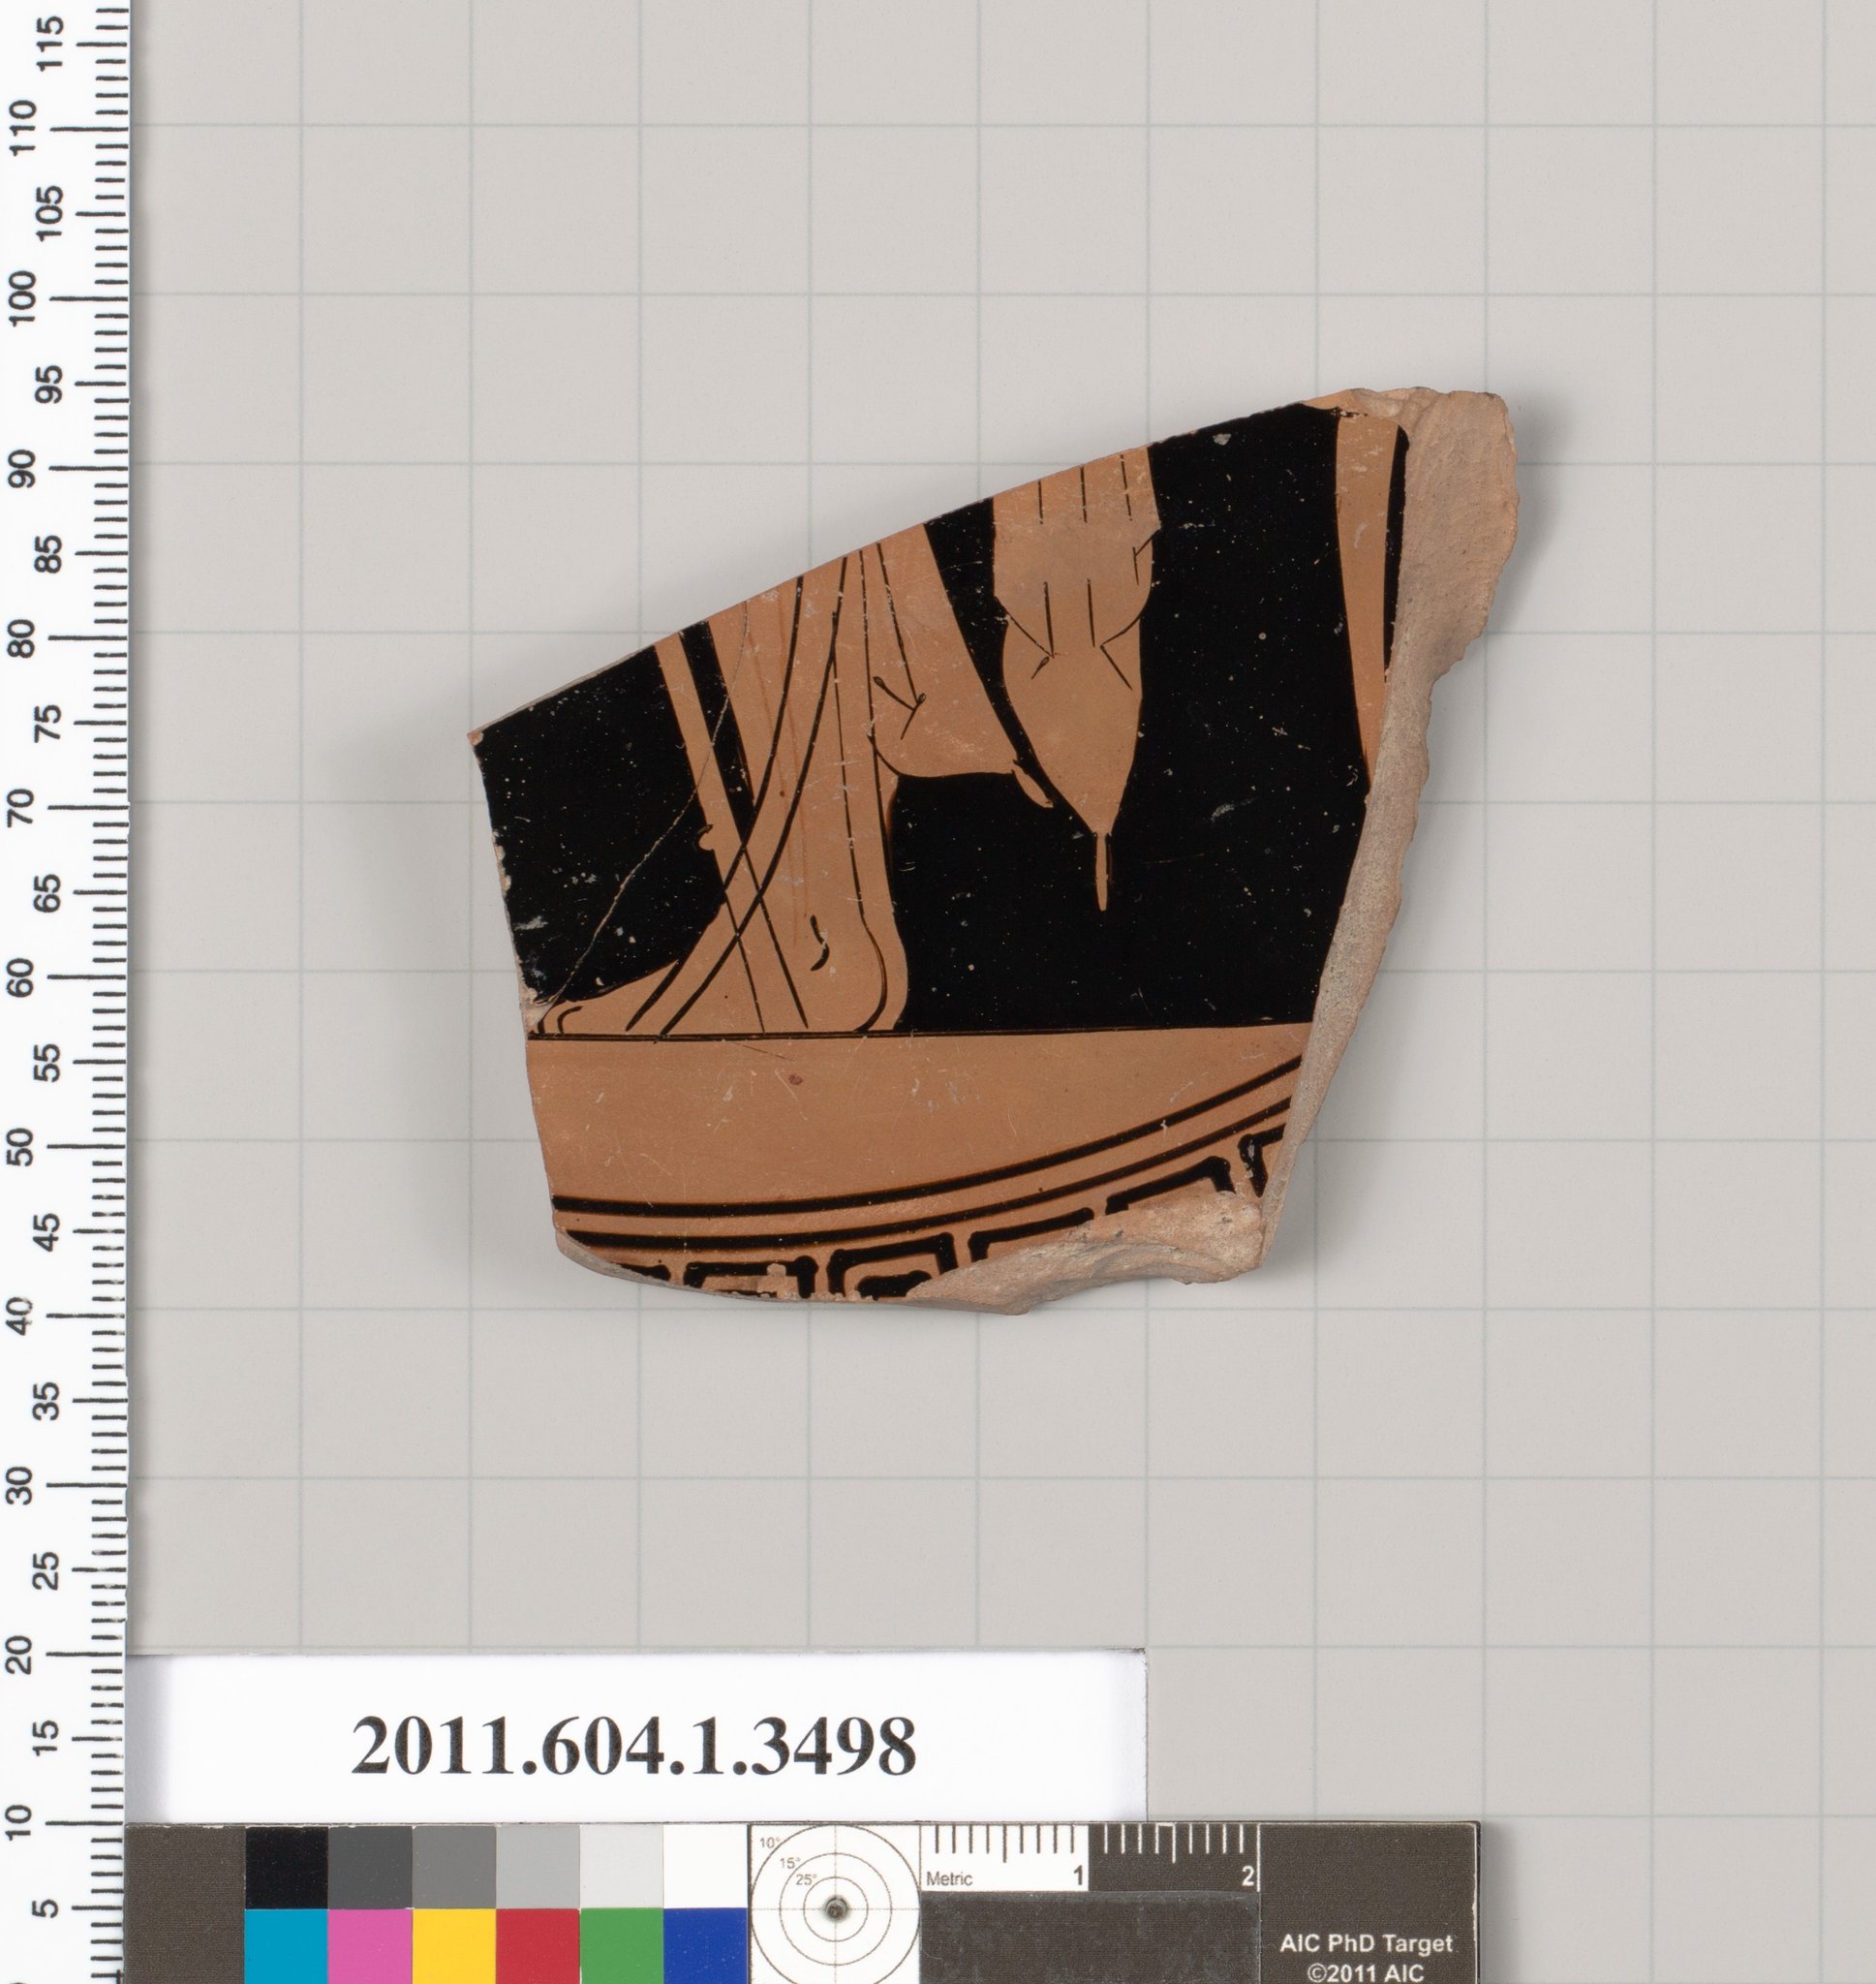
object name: kylix fragment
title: Terracotta fragment of a kylix (drinking cup)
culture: greek, attic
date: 490-480 BCE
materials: terracotta